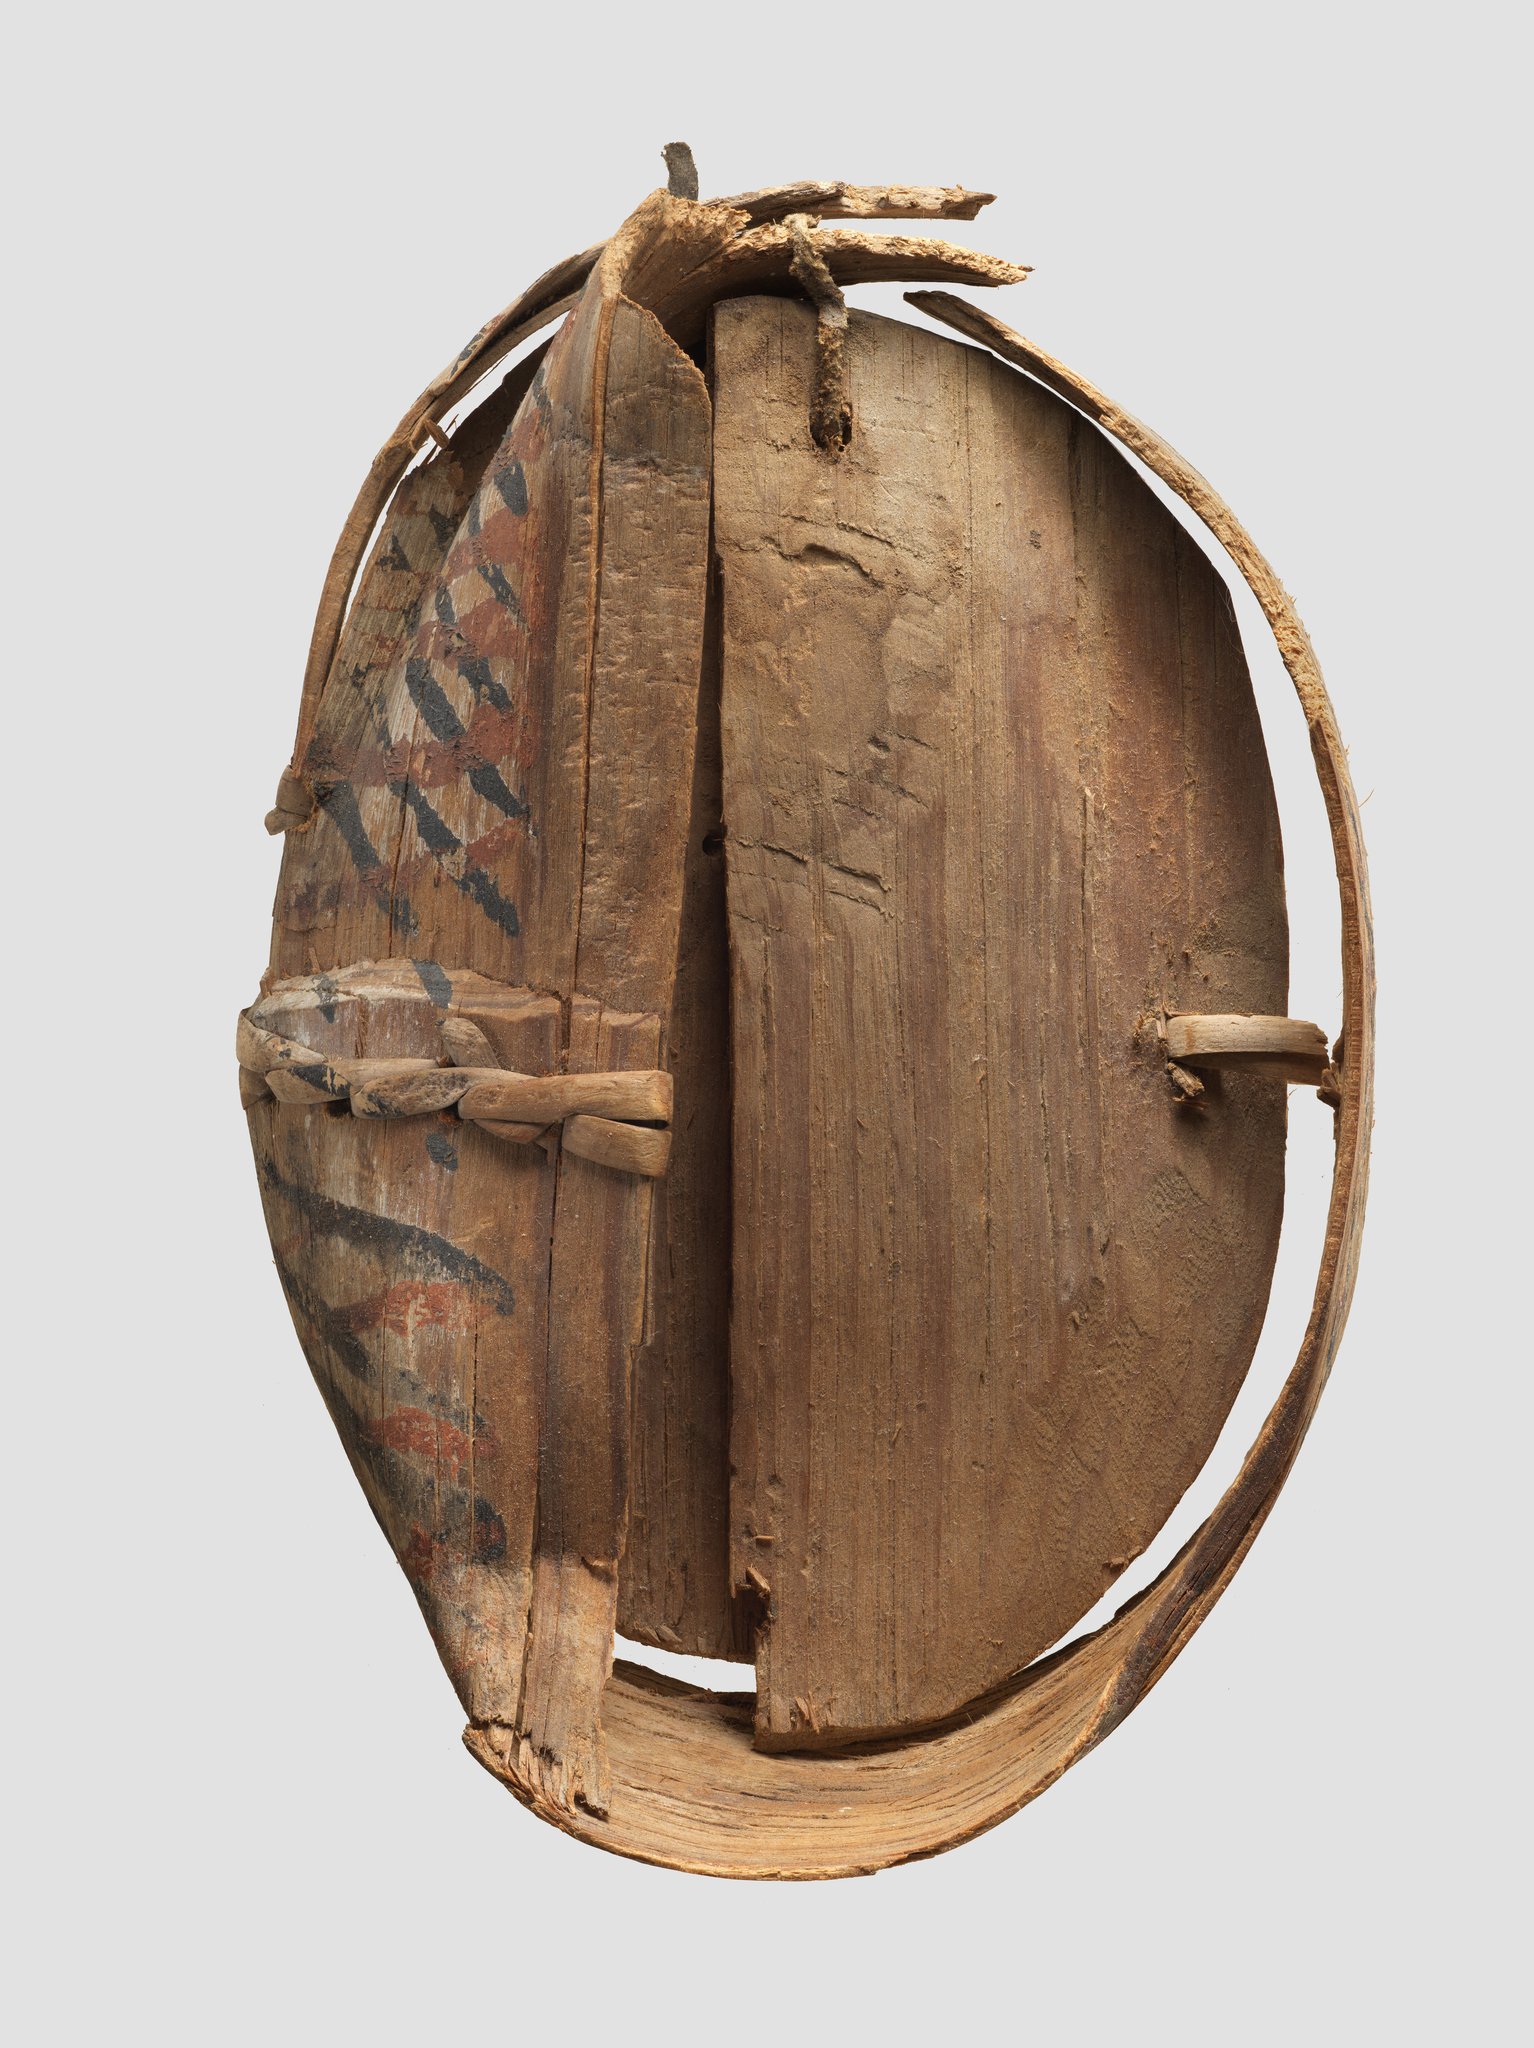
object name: box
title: Oval birch box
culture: alanic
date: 601-900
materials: wood, paint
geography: caucasus